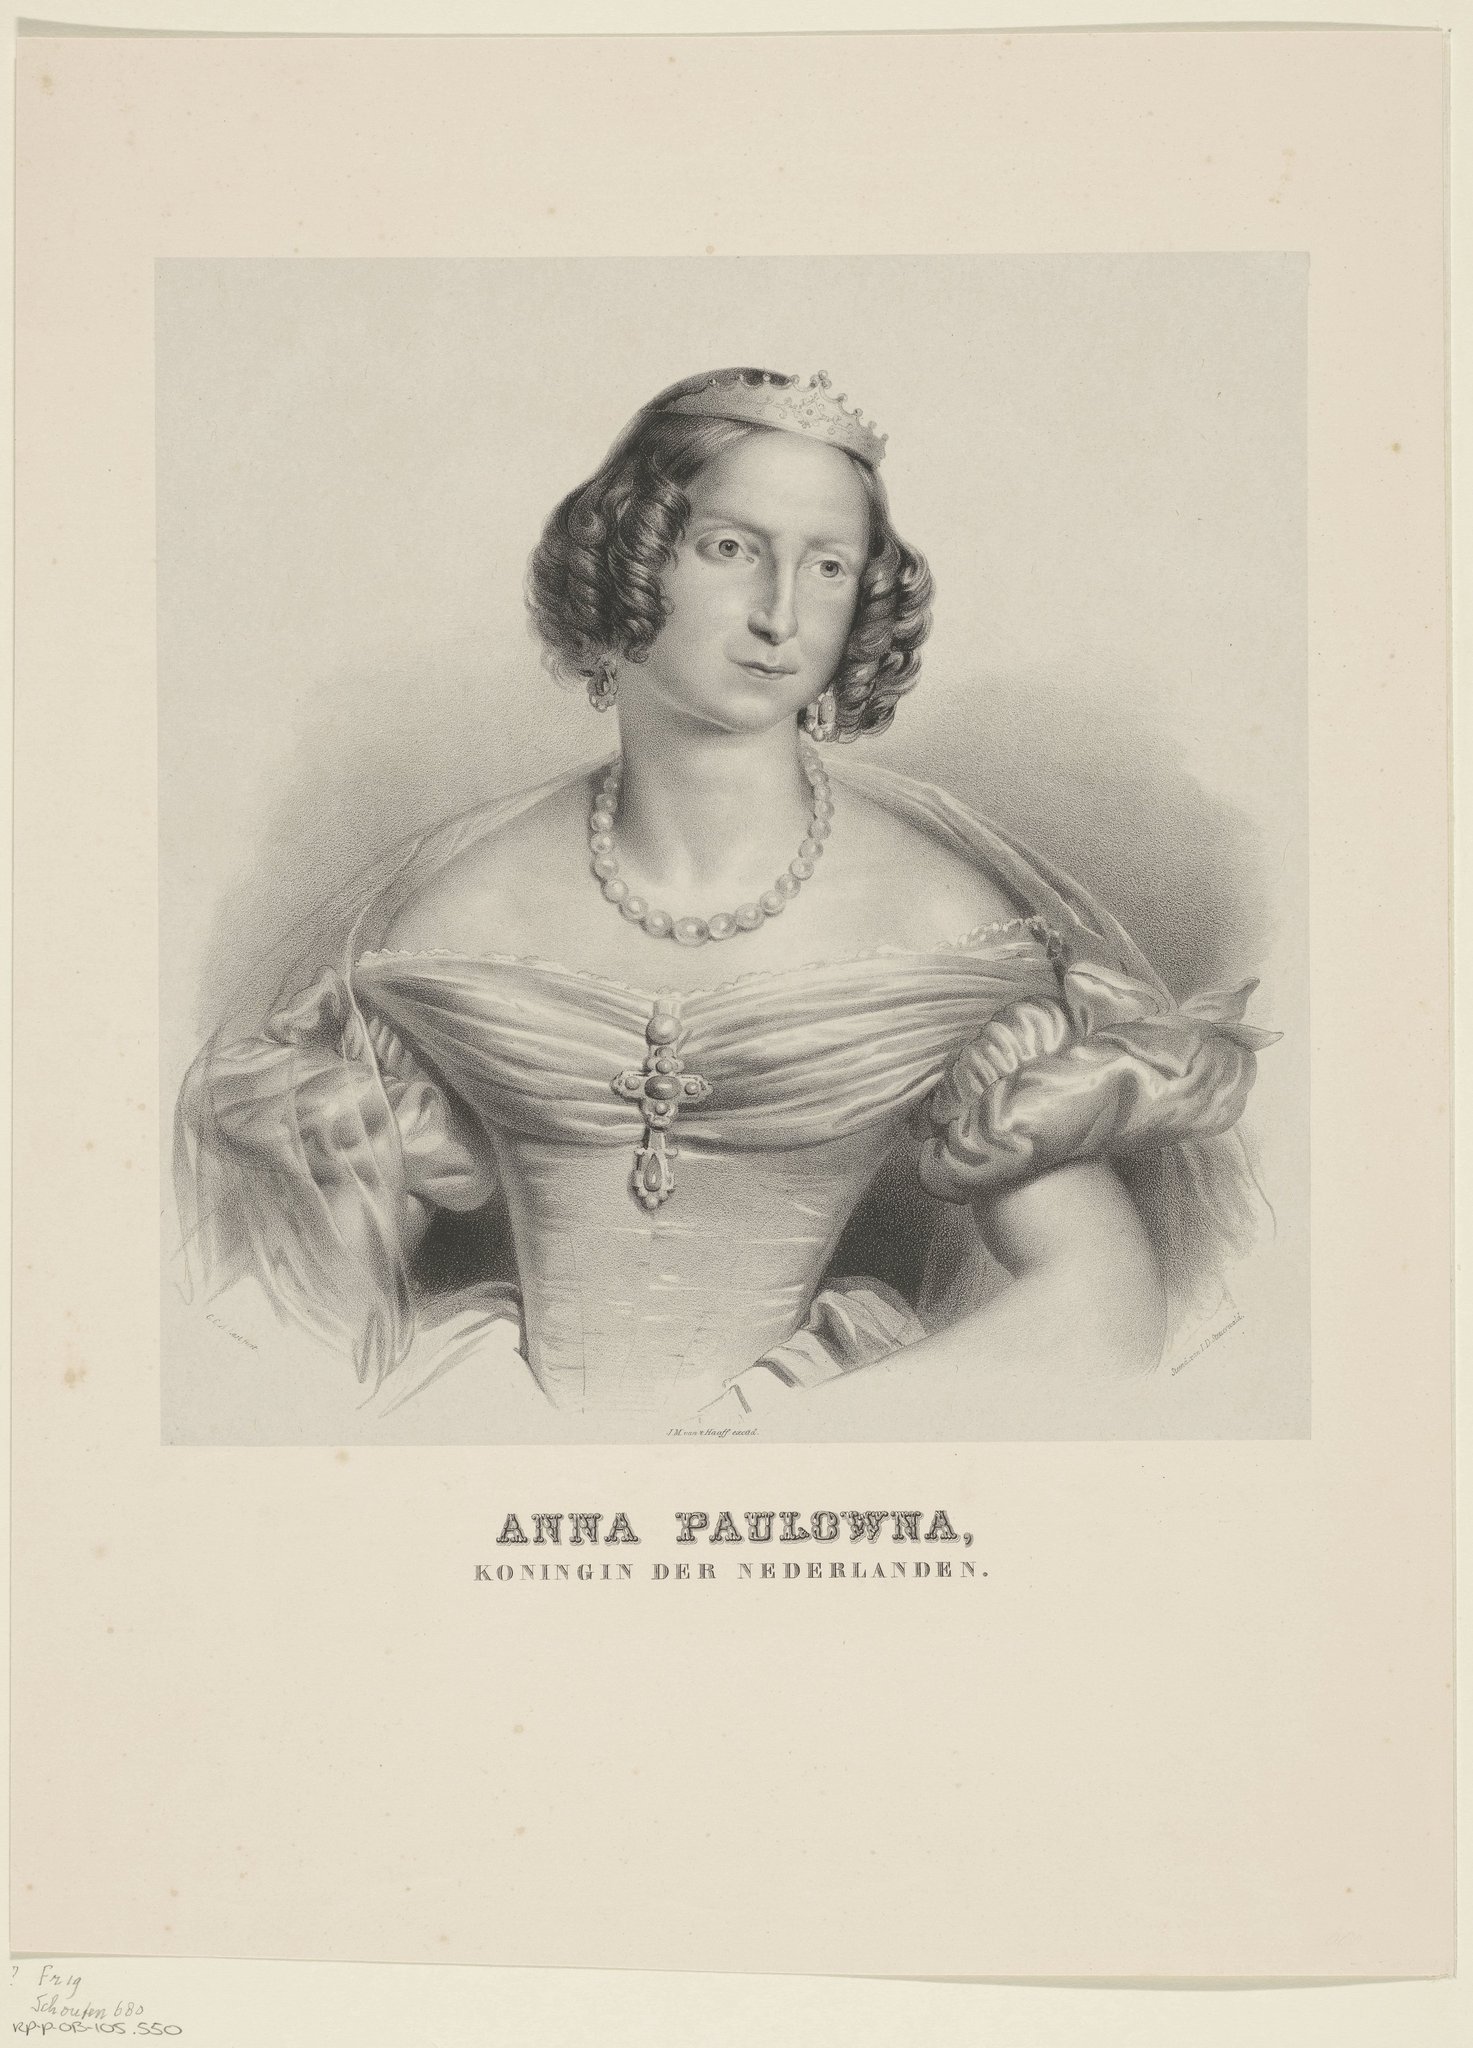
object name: print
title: Portret van Anna Paulowna Romanowa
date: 1840-1863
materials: paper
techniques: lithograph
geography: the hague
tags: the hague, anna paulowna romanowa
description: Portret van Anna Paulowna. In de ondermarge haar naam en titel.